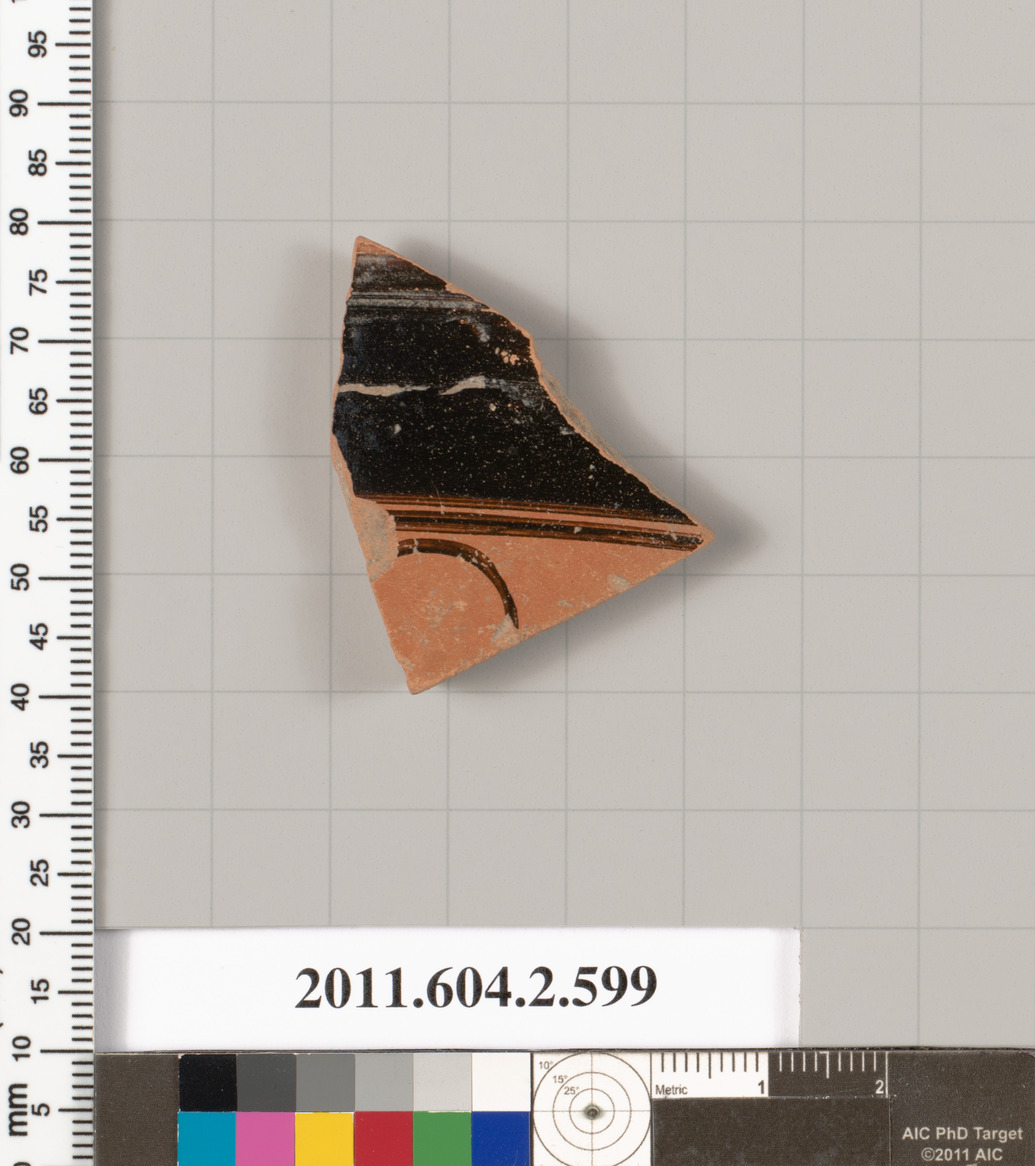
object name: column krater fragment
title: Terracotta fragment of a column-krater (bowl for mixing wine and water)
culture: greek, attic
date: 470-440 BCE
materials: terracotta